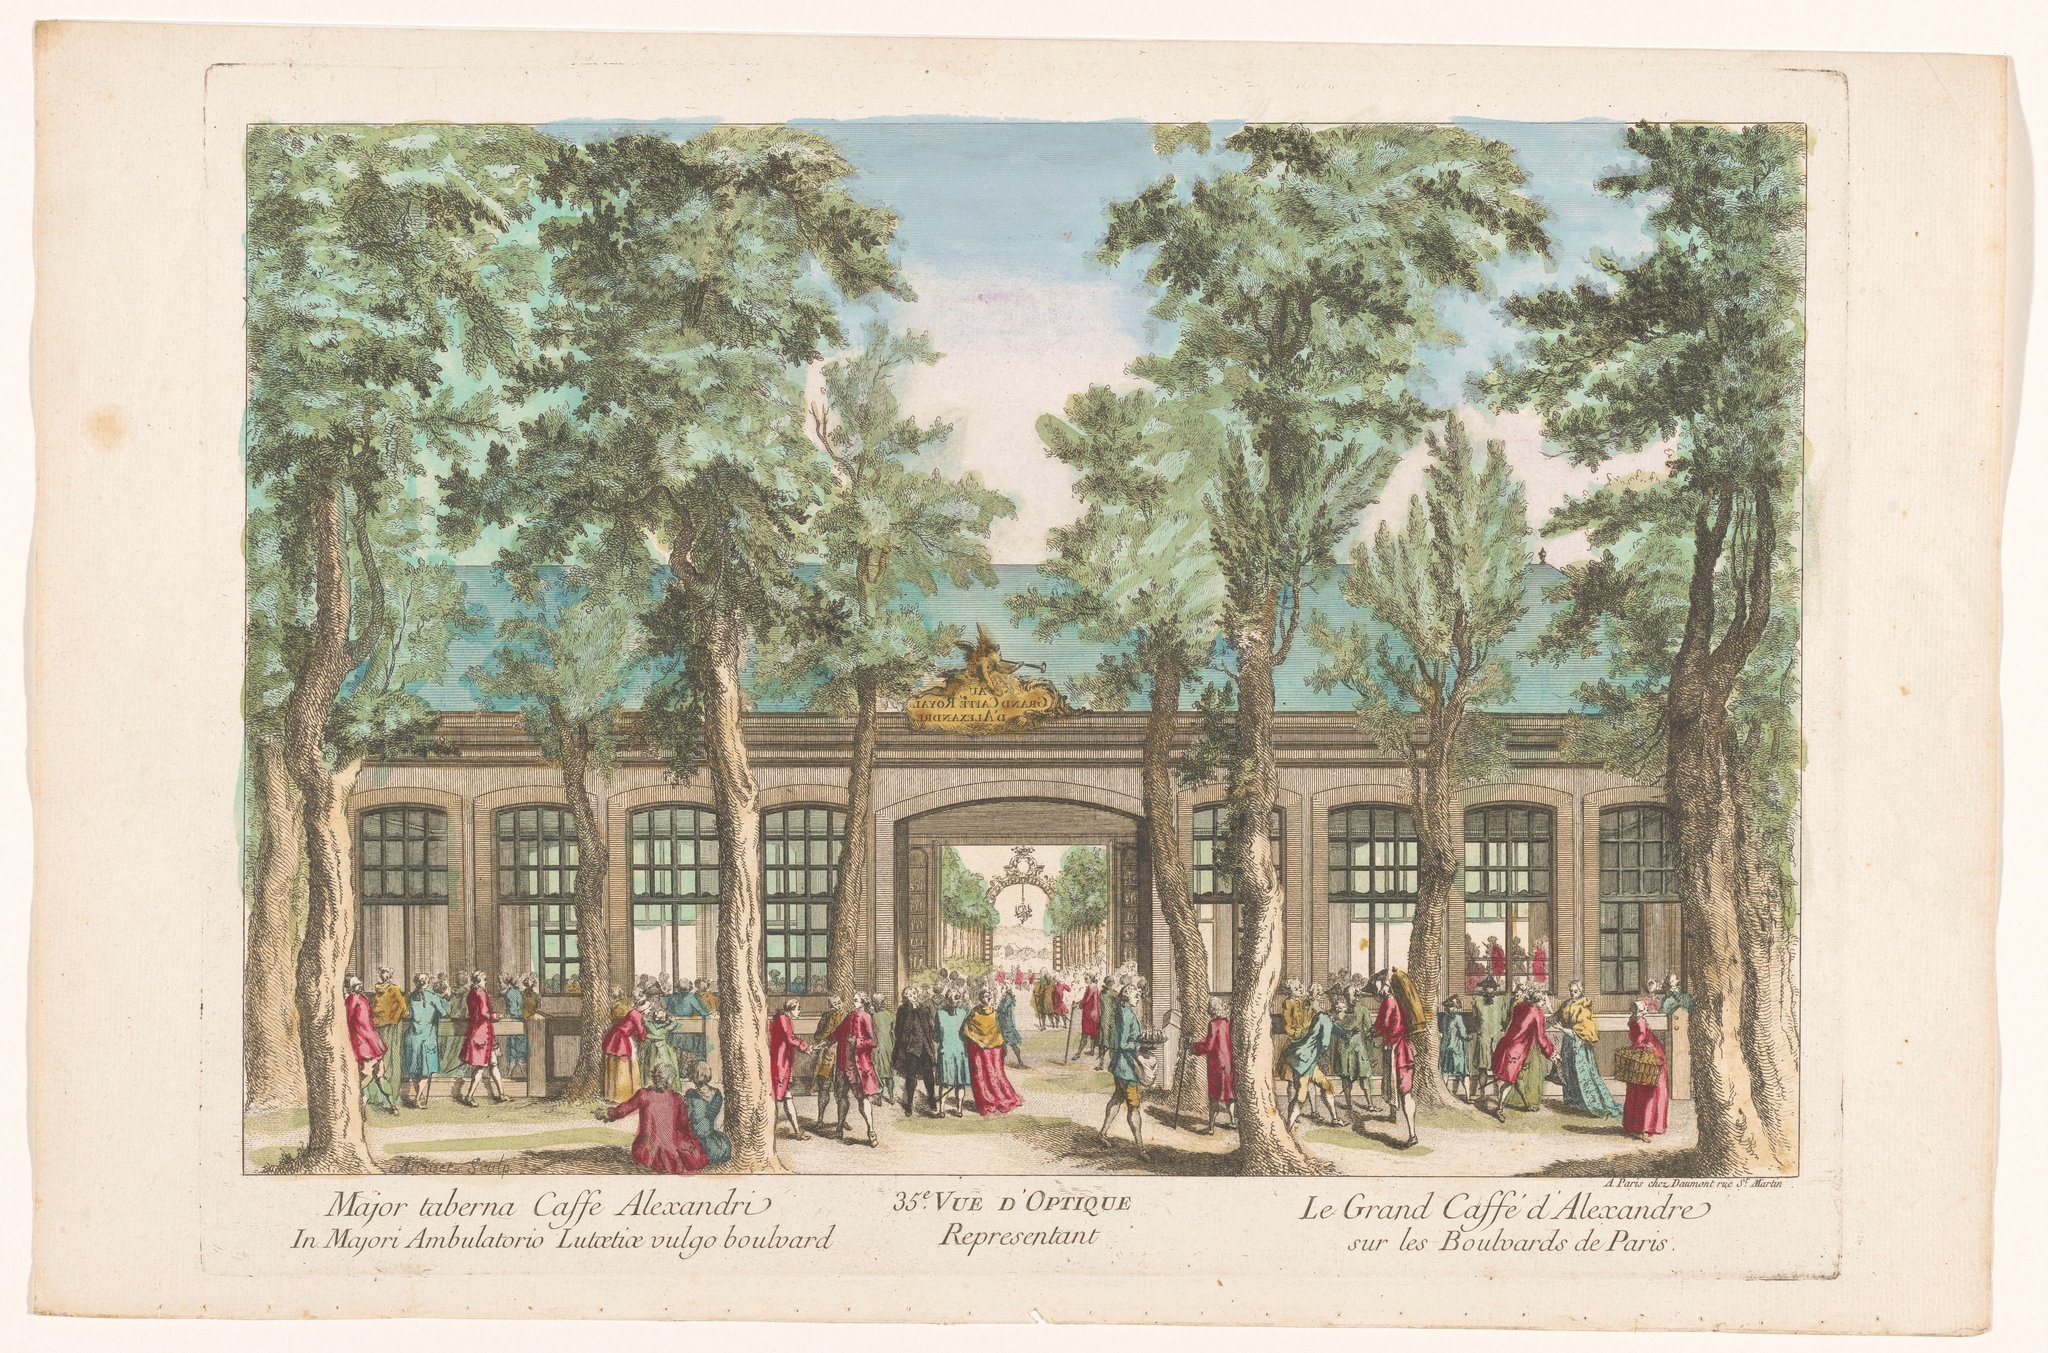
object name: print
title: Gezicht op het Grand Caffé Royal d´Alexandre op de Boulevard du Temple te Parijs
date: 1745-1775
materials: paper, watercolor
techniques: brush, etching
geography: paris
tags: avenue, boulevard, promenade, esplanade (+ city(-scape) with figures, staffage), inn, coffee-house, public house, etc.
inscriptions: collector's mark: Lugt 2166, watermark